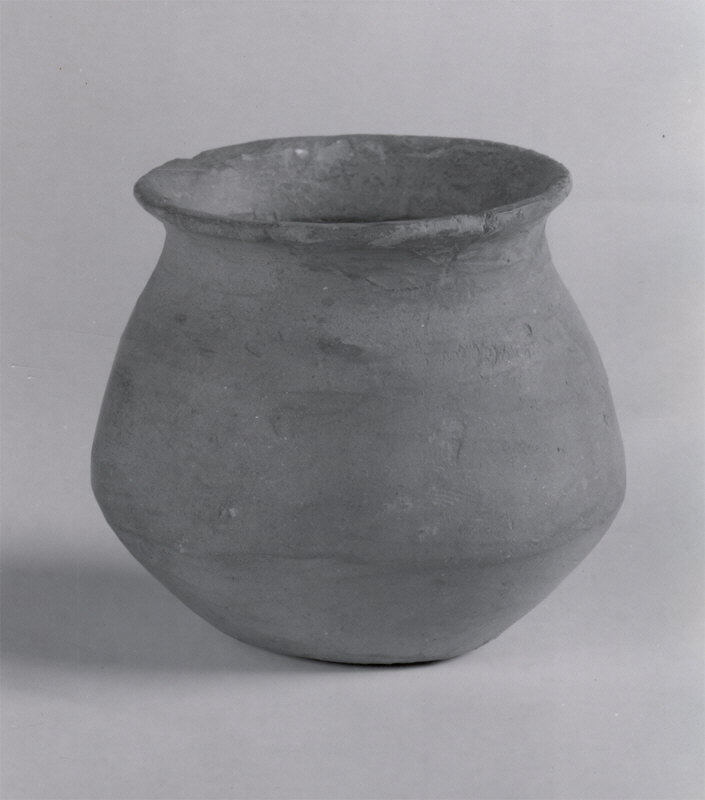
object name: jar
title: Small jar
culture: iranian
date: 700-601 BCE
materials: ceramic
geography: iran